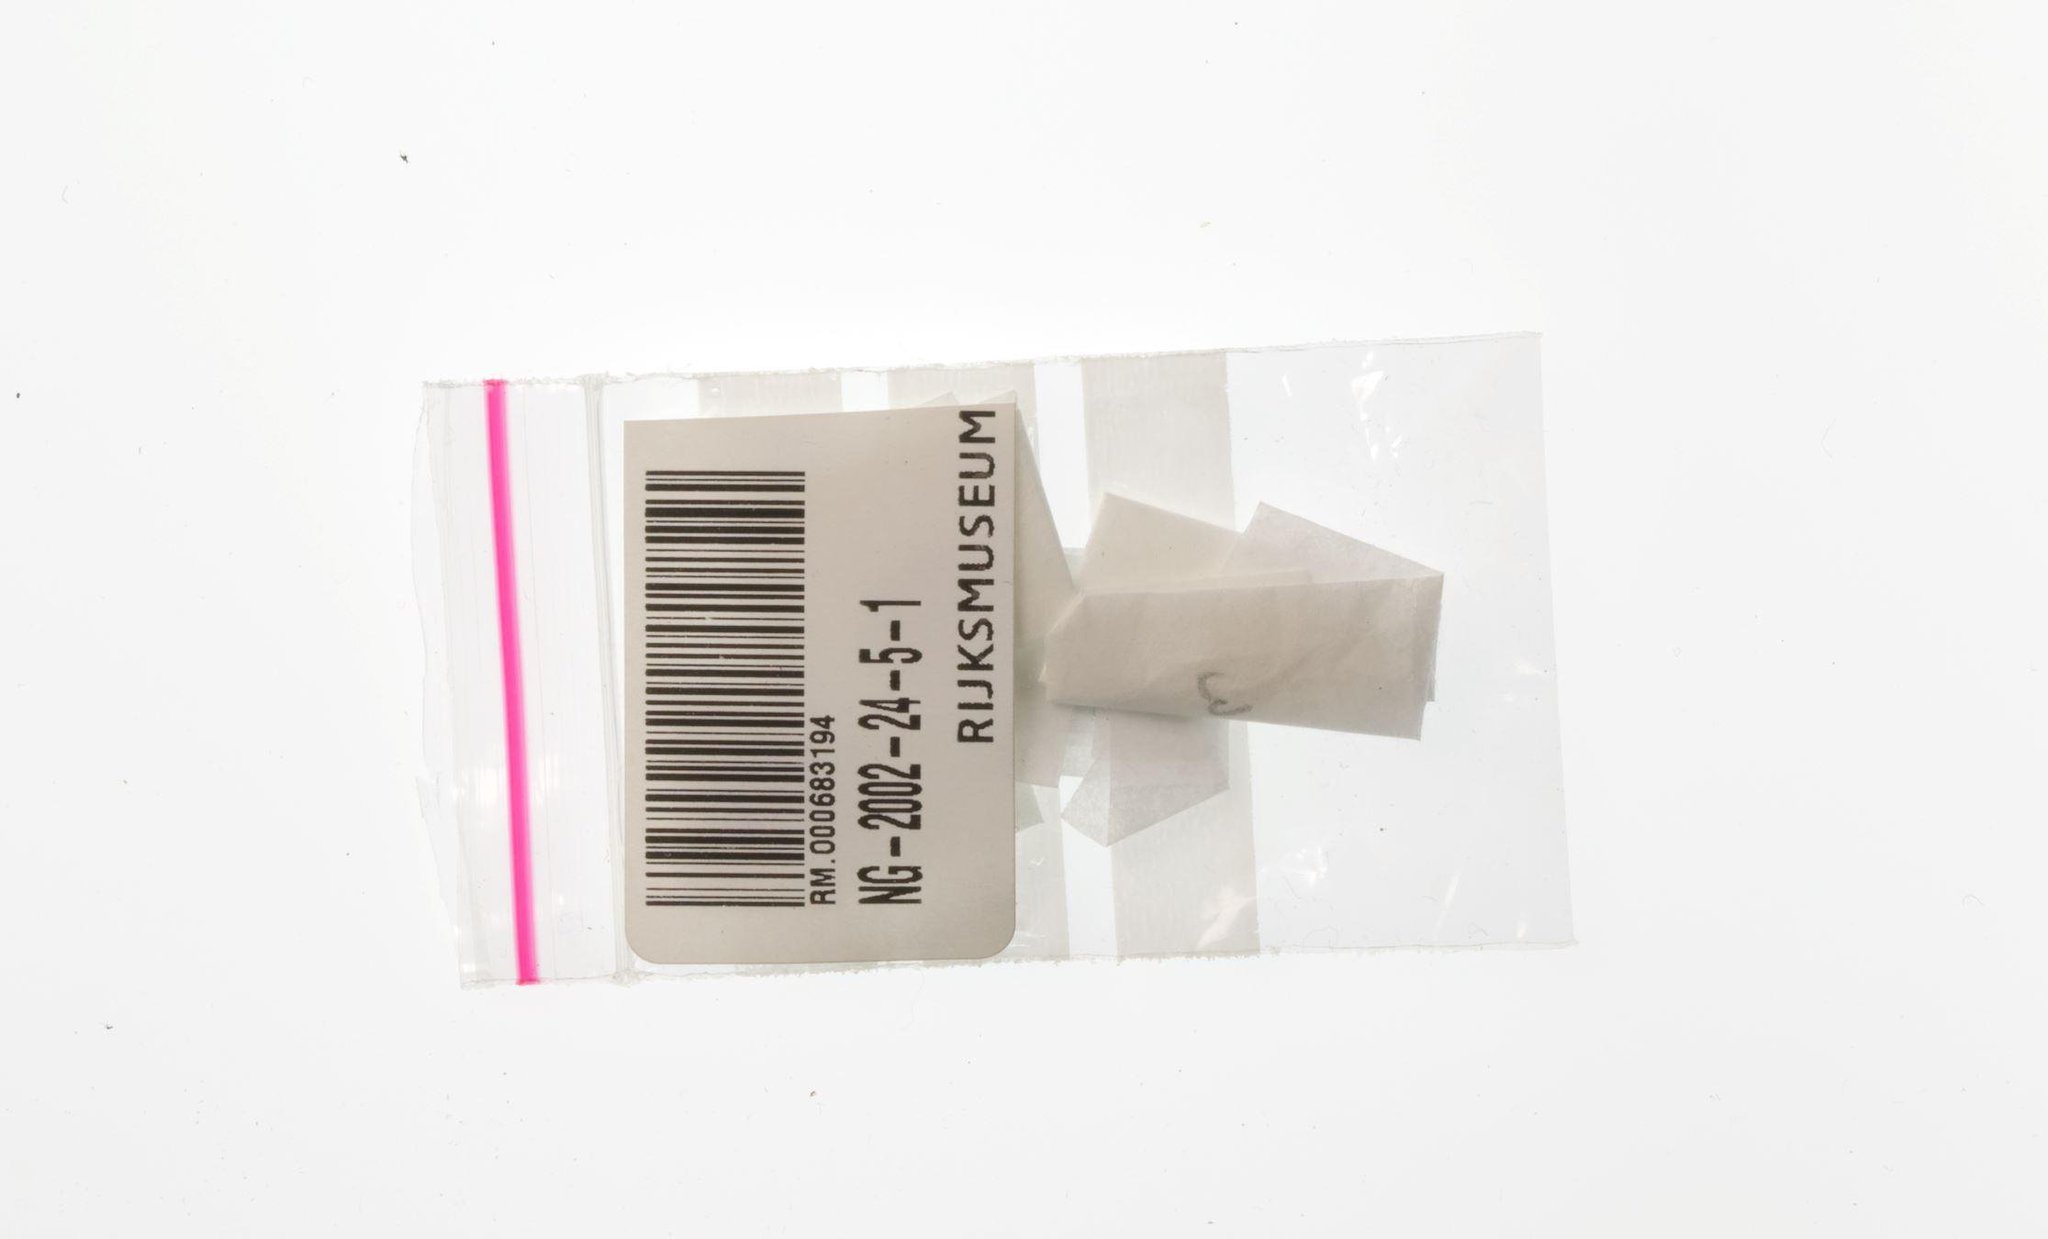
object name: sherd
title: Vier scherven behorend bij vier glazen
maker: Anonymous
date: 1700-1790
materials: glass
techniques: painted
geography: netherlands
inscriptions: label: ‘'Gebrandschilderde glazen. Collectie I.S. van der Schaaff, Baarn. Nummer 5 (vijf) inhoudende vier glazen, voorstellende vier ambachten, ongeschonden en heel op 16 februarij 1886.'’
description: Vier scherven afkomstig van vier glazen in een houten vatting met handvat.